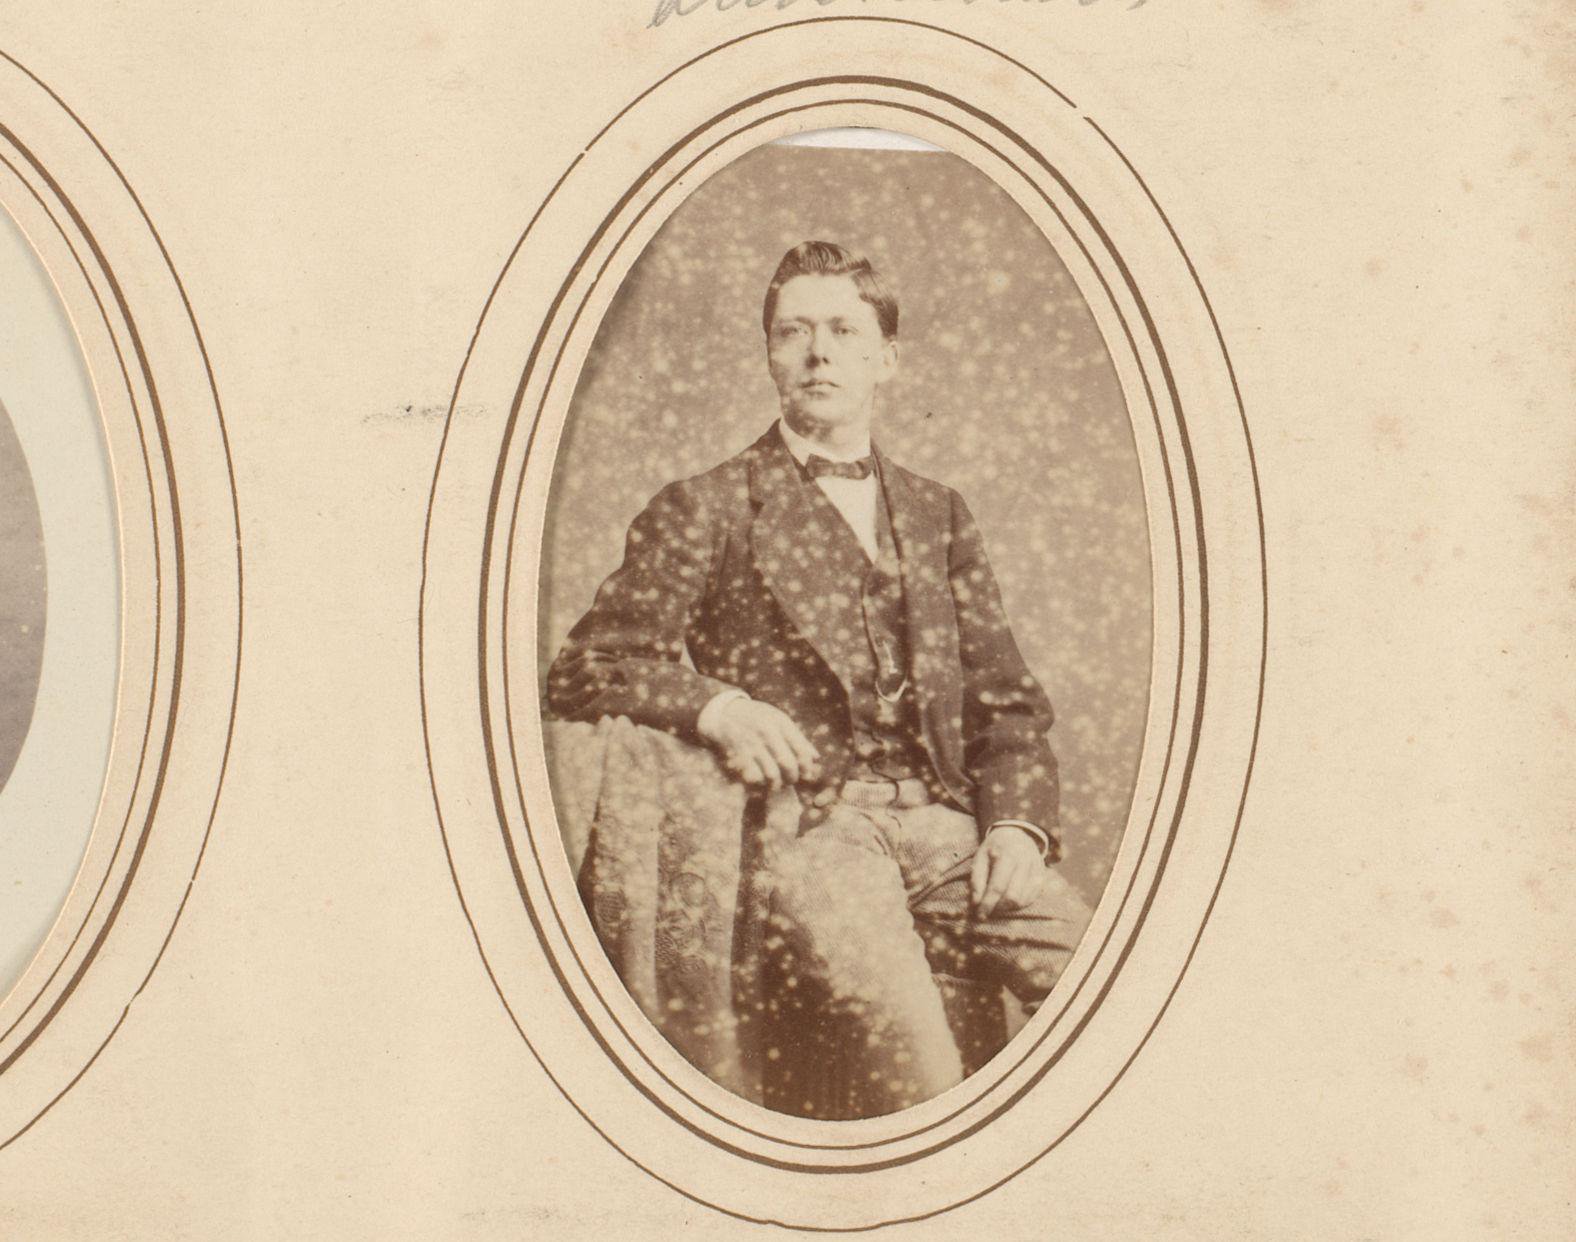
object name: carte de visite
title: Portret van een man, mogelijk F.J.G. Dedel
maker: johannes wilhelmus franciscus offenberg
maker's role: fotograaf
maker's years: 1839-1919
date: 1874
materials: cardboard, photographic support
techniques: albumen print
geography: amsterdam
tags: adult man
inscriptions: inscription: ‘Offenberg/ Photographe / de S.M. la Reine des Pays-Bas / Damstraat / Amsterdam.’, annotation: ‘F.J.G. Dedel / 18 20/2 74’